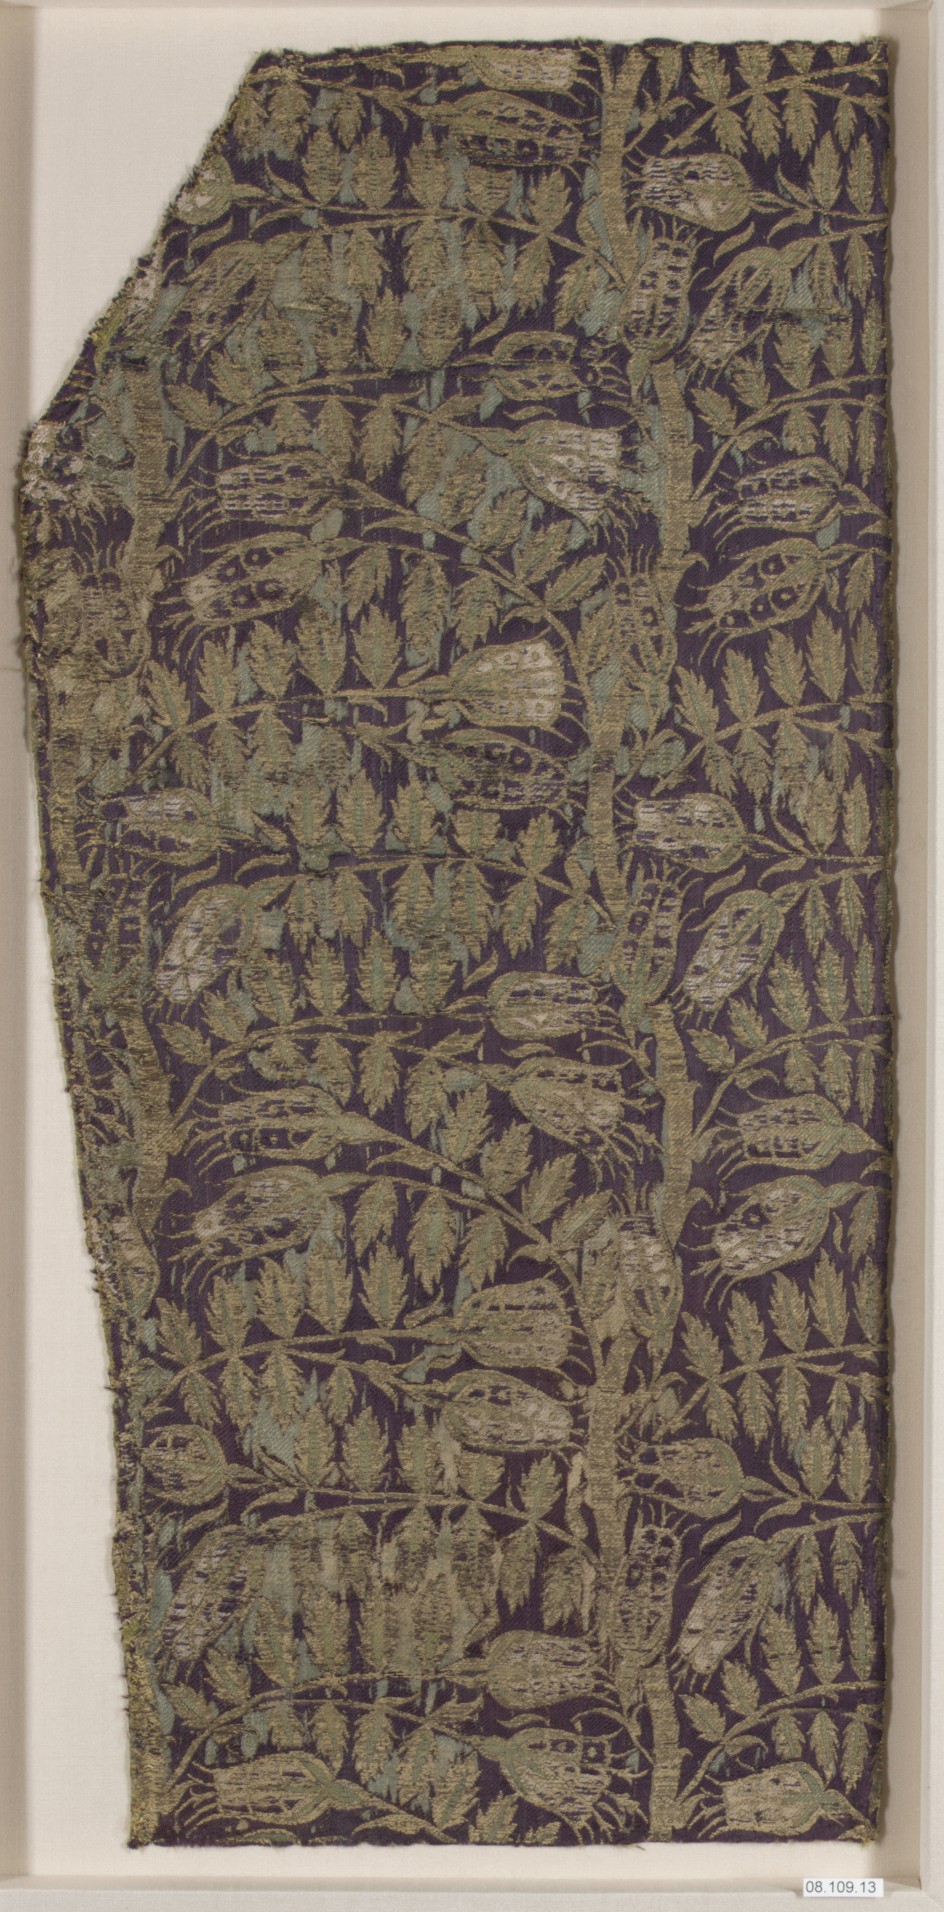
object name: textile fragment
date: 1601-1700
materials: metal thread, silk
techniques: lampas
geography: turkey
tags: flowers,leaves